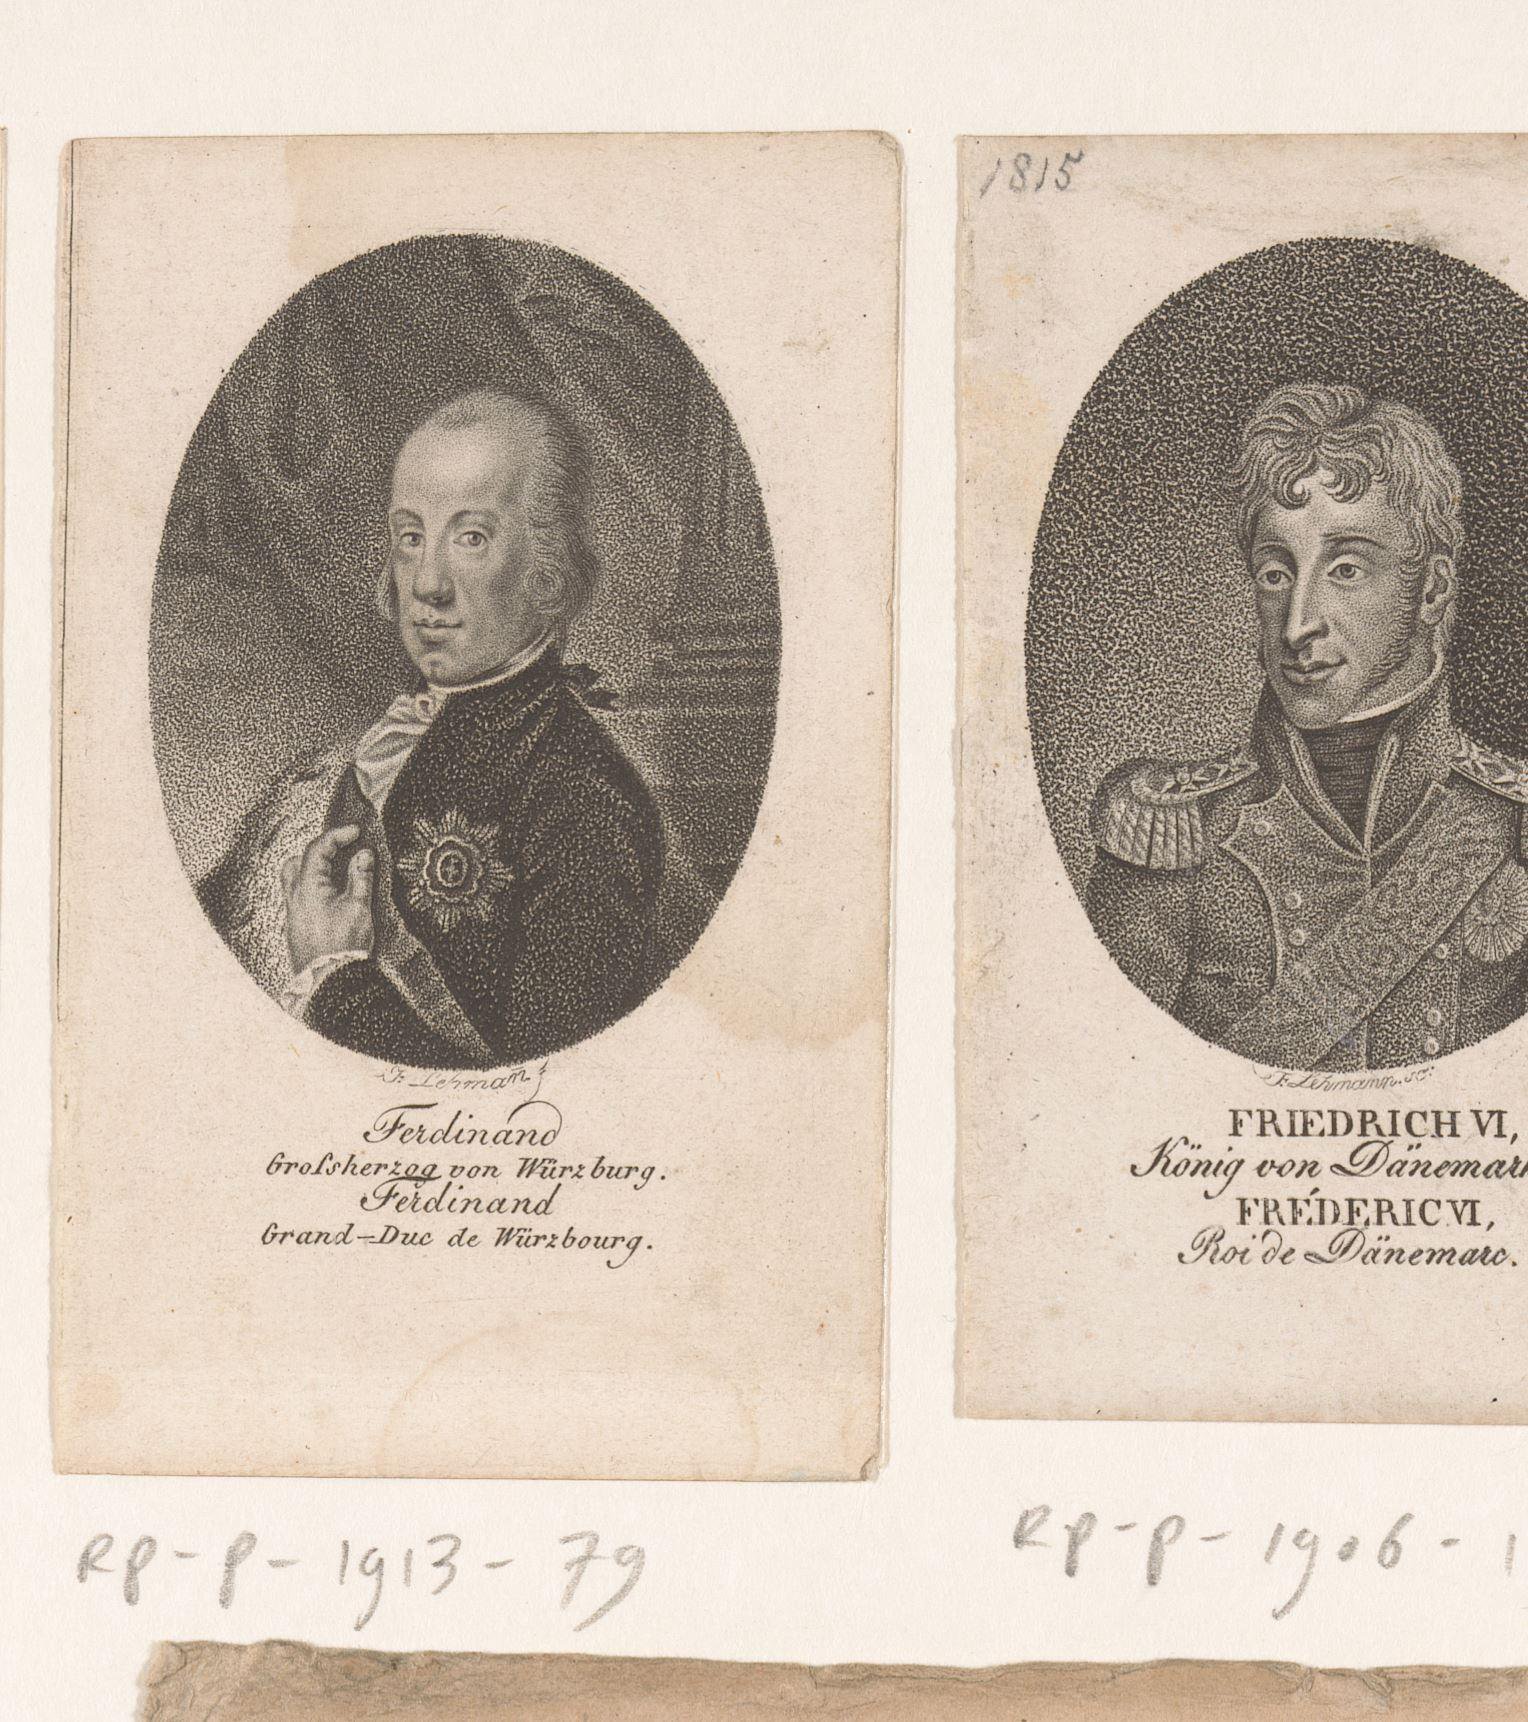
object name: print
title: Portret van Ferdinand III van Toscane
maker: friedrich leonhard lehmann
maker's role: print maker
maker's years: 1787-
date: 1797-1886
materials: paper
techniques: engraving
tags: ferdinand iii (groothertog van toscane), historical persons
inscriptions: collector's mark: Lugt 2228